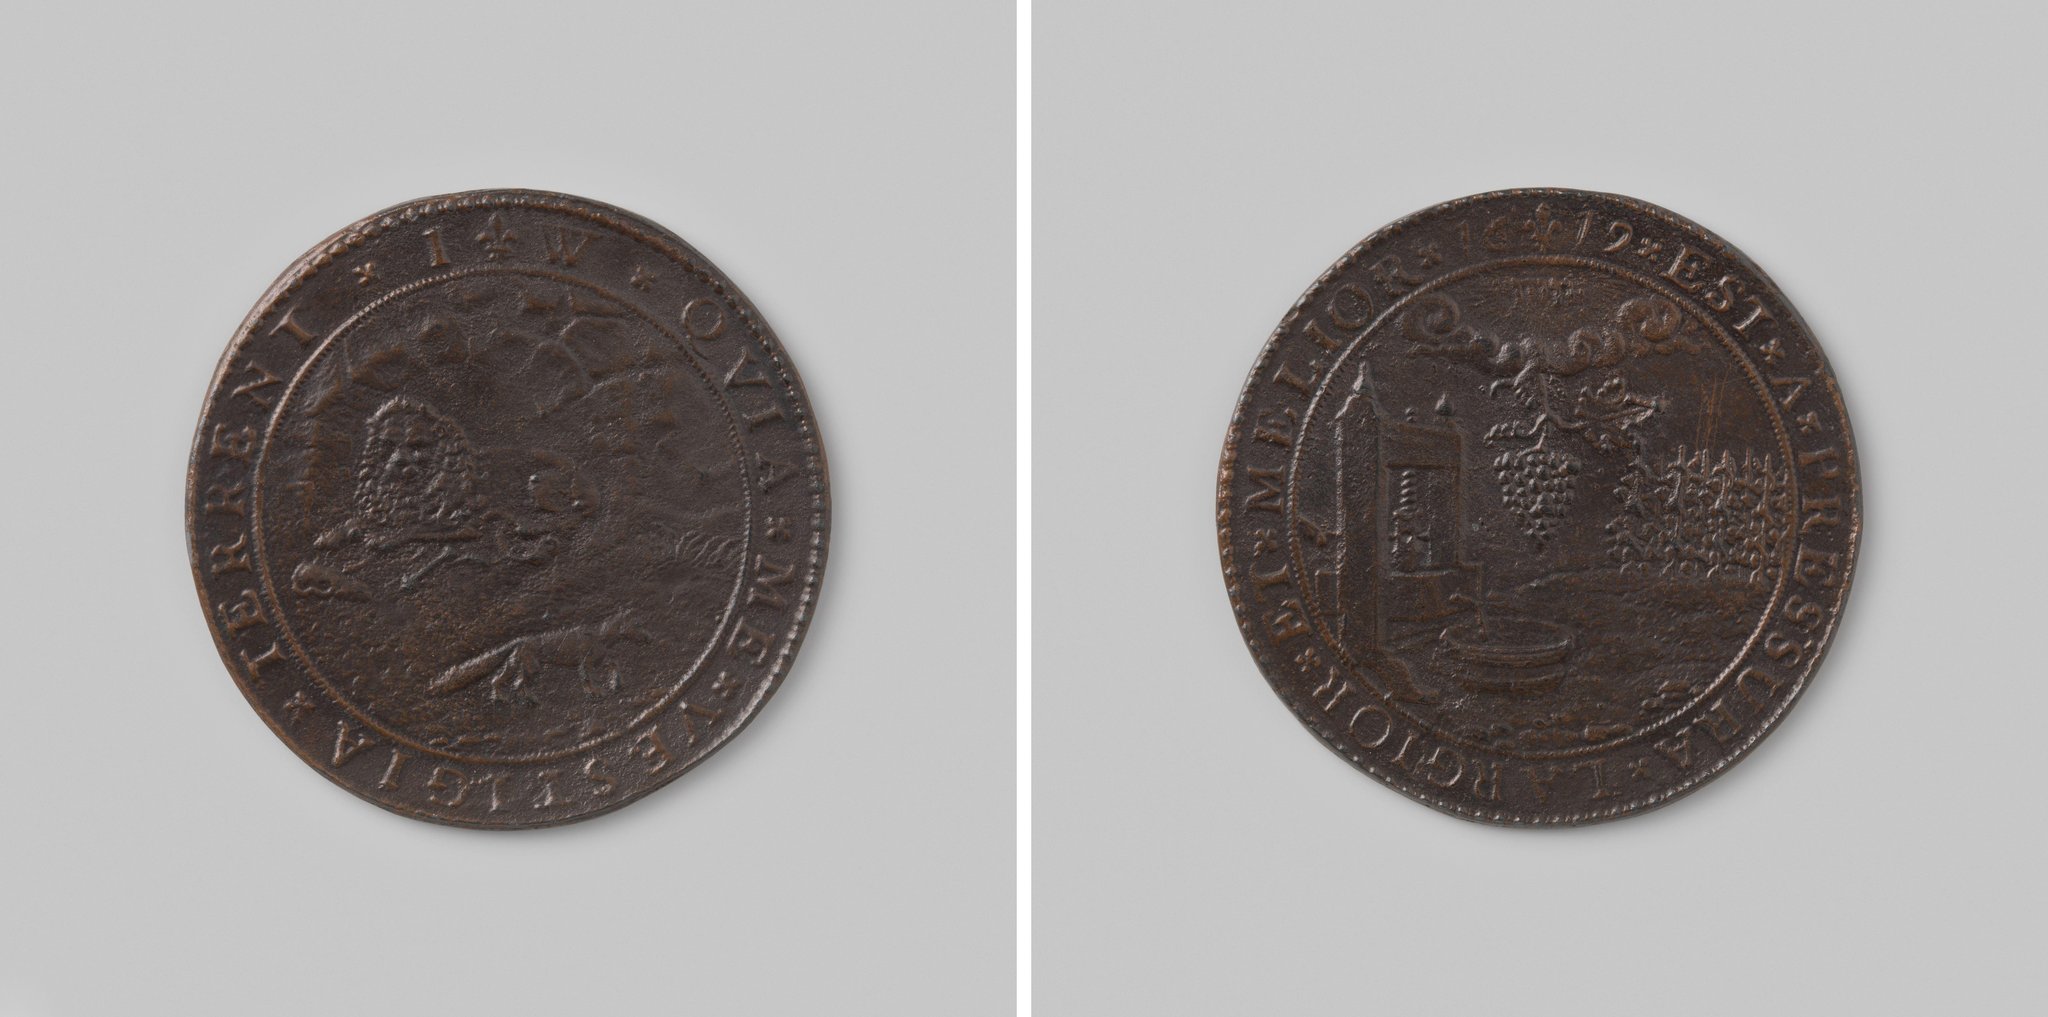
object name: history medal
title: J. Uytenbogaerd voor de Synode gedaagd 1619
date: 1619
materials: tin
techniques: casting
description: Tinnen penning, op de voorzijde een leeuw in een grot waaraan een vos voorbijgaat, met omschrift, op de keerzijde een wijnpers bij een wijngaard waarboven een wolk met de stralende naam Gods waaruit een hand die een druiventros aanreikt, met omschrift.